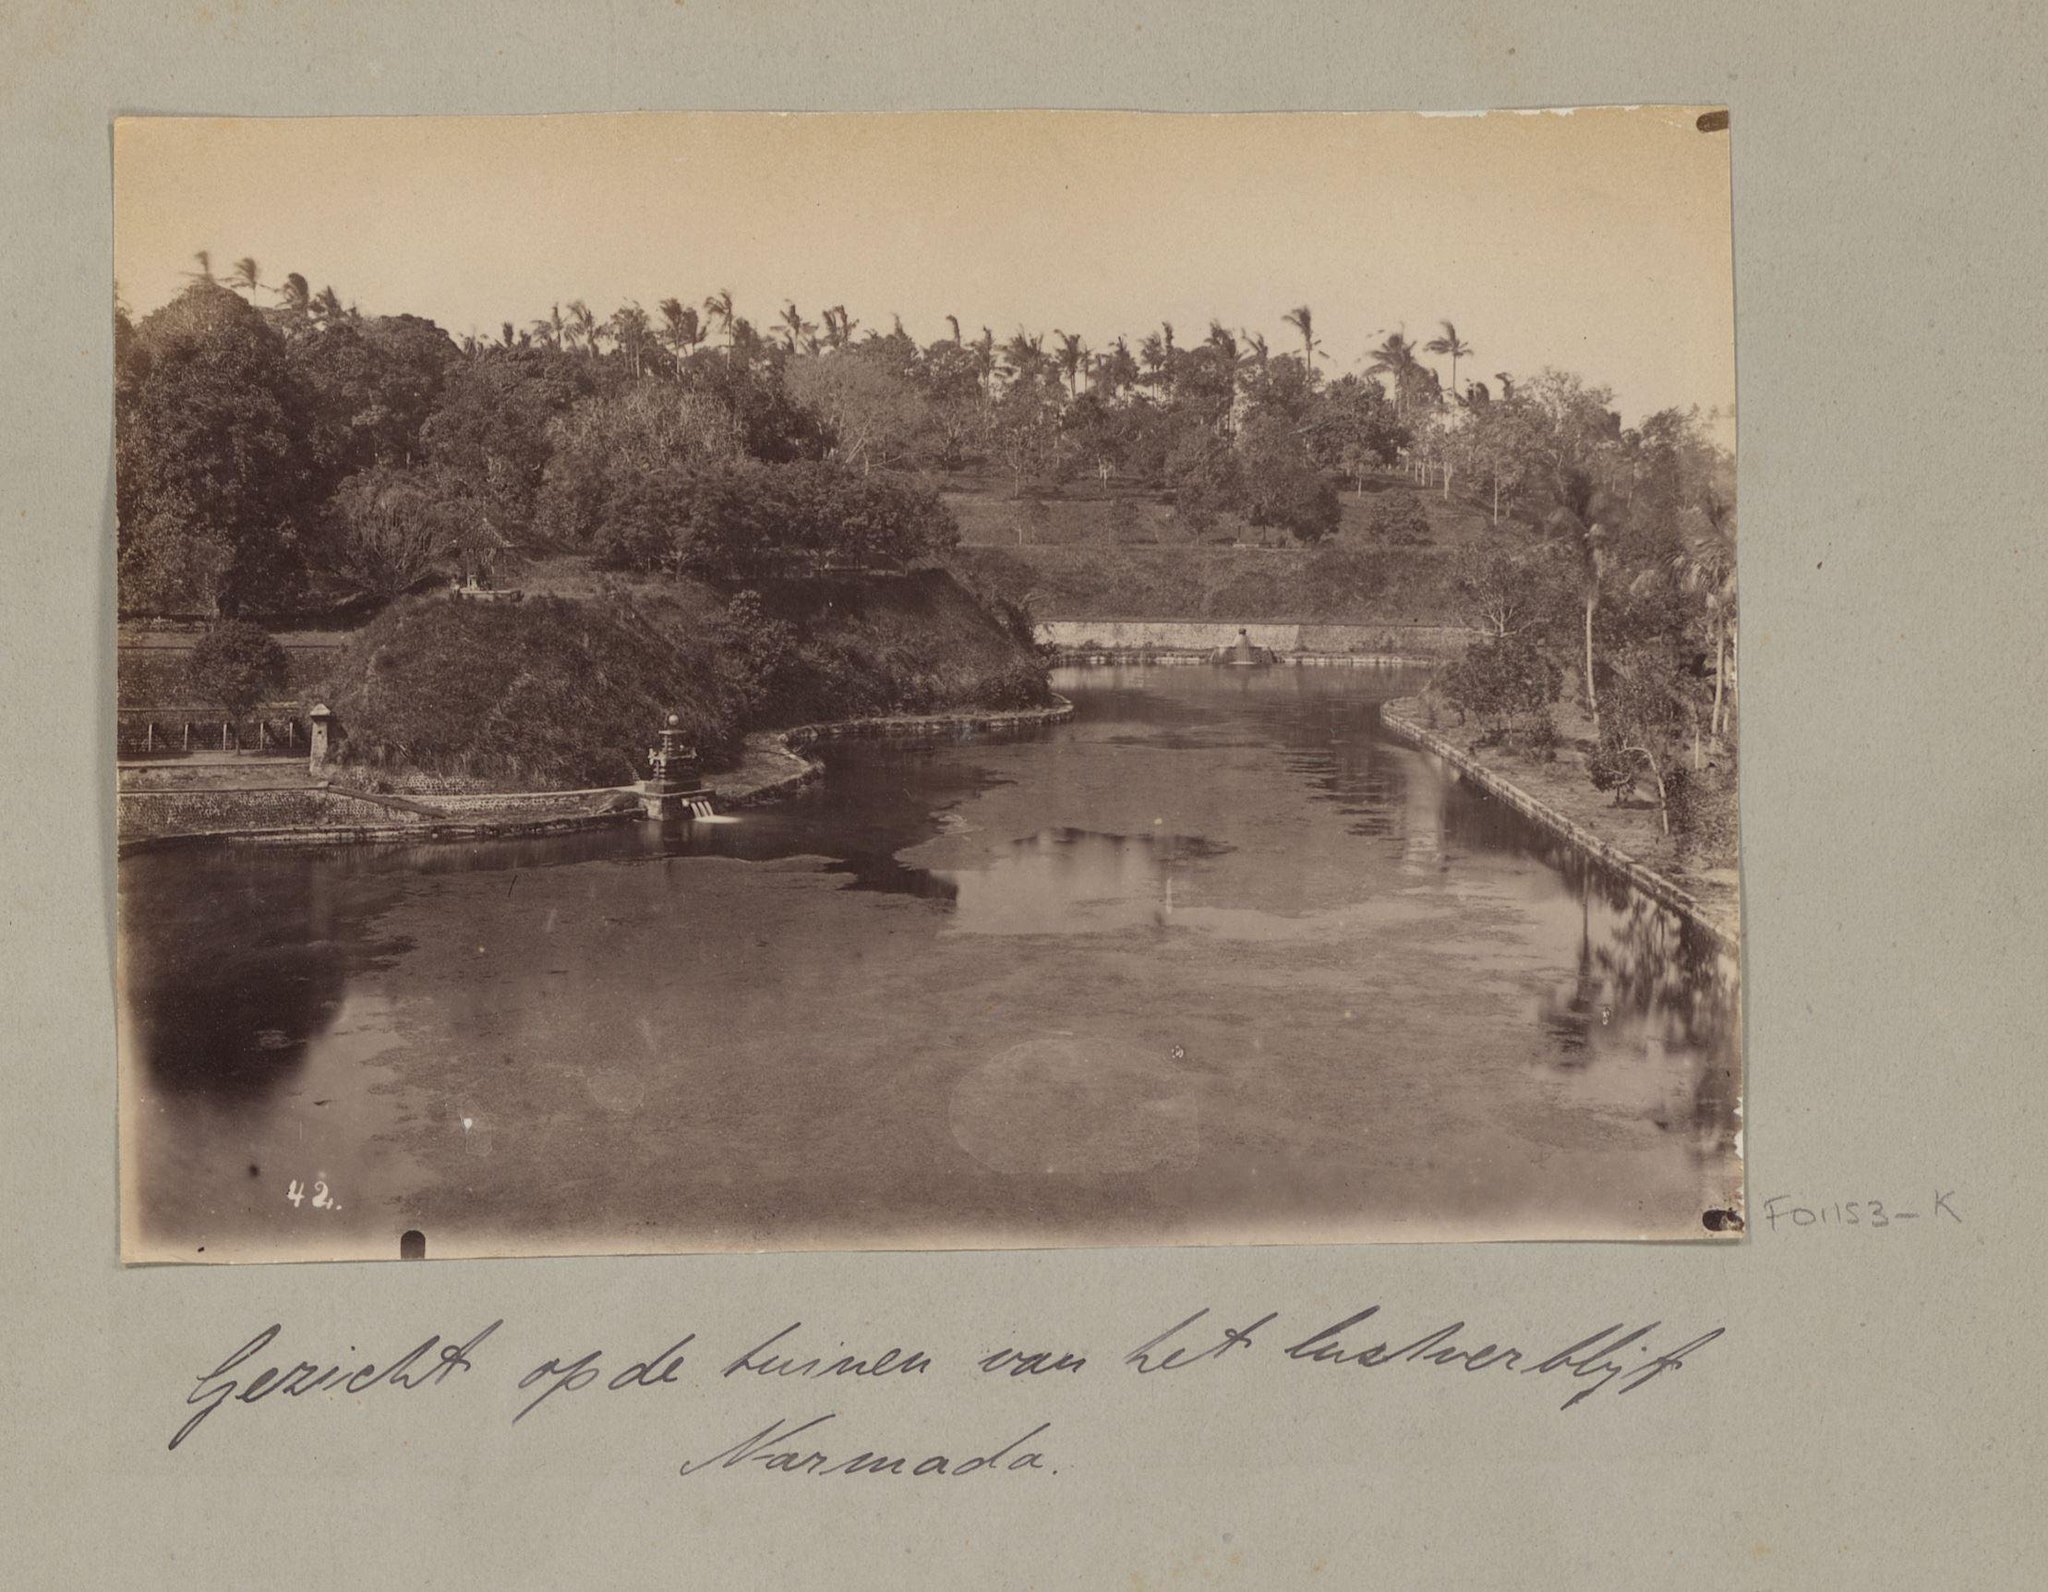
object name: album leaf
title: Gezicht op Taman Narmada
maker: christiaan johan neeb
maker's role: arts, fotograaf, officier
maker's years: 1860-1925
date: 1894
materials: photographic support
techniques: albumen print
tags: park, landscapes with waters, waterscapes, seascapes (in the temperate zone), dutch east indies, the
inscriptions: number: ‘42.’